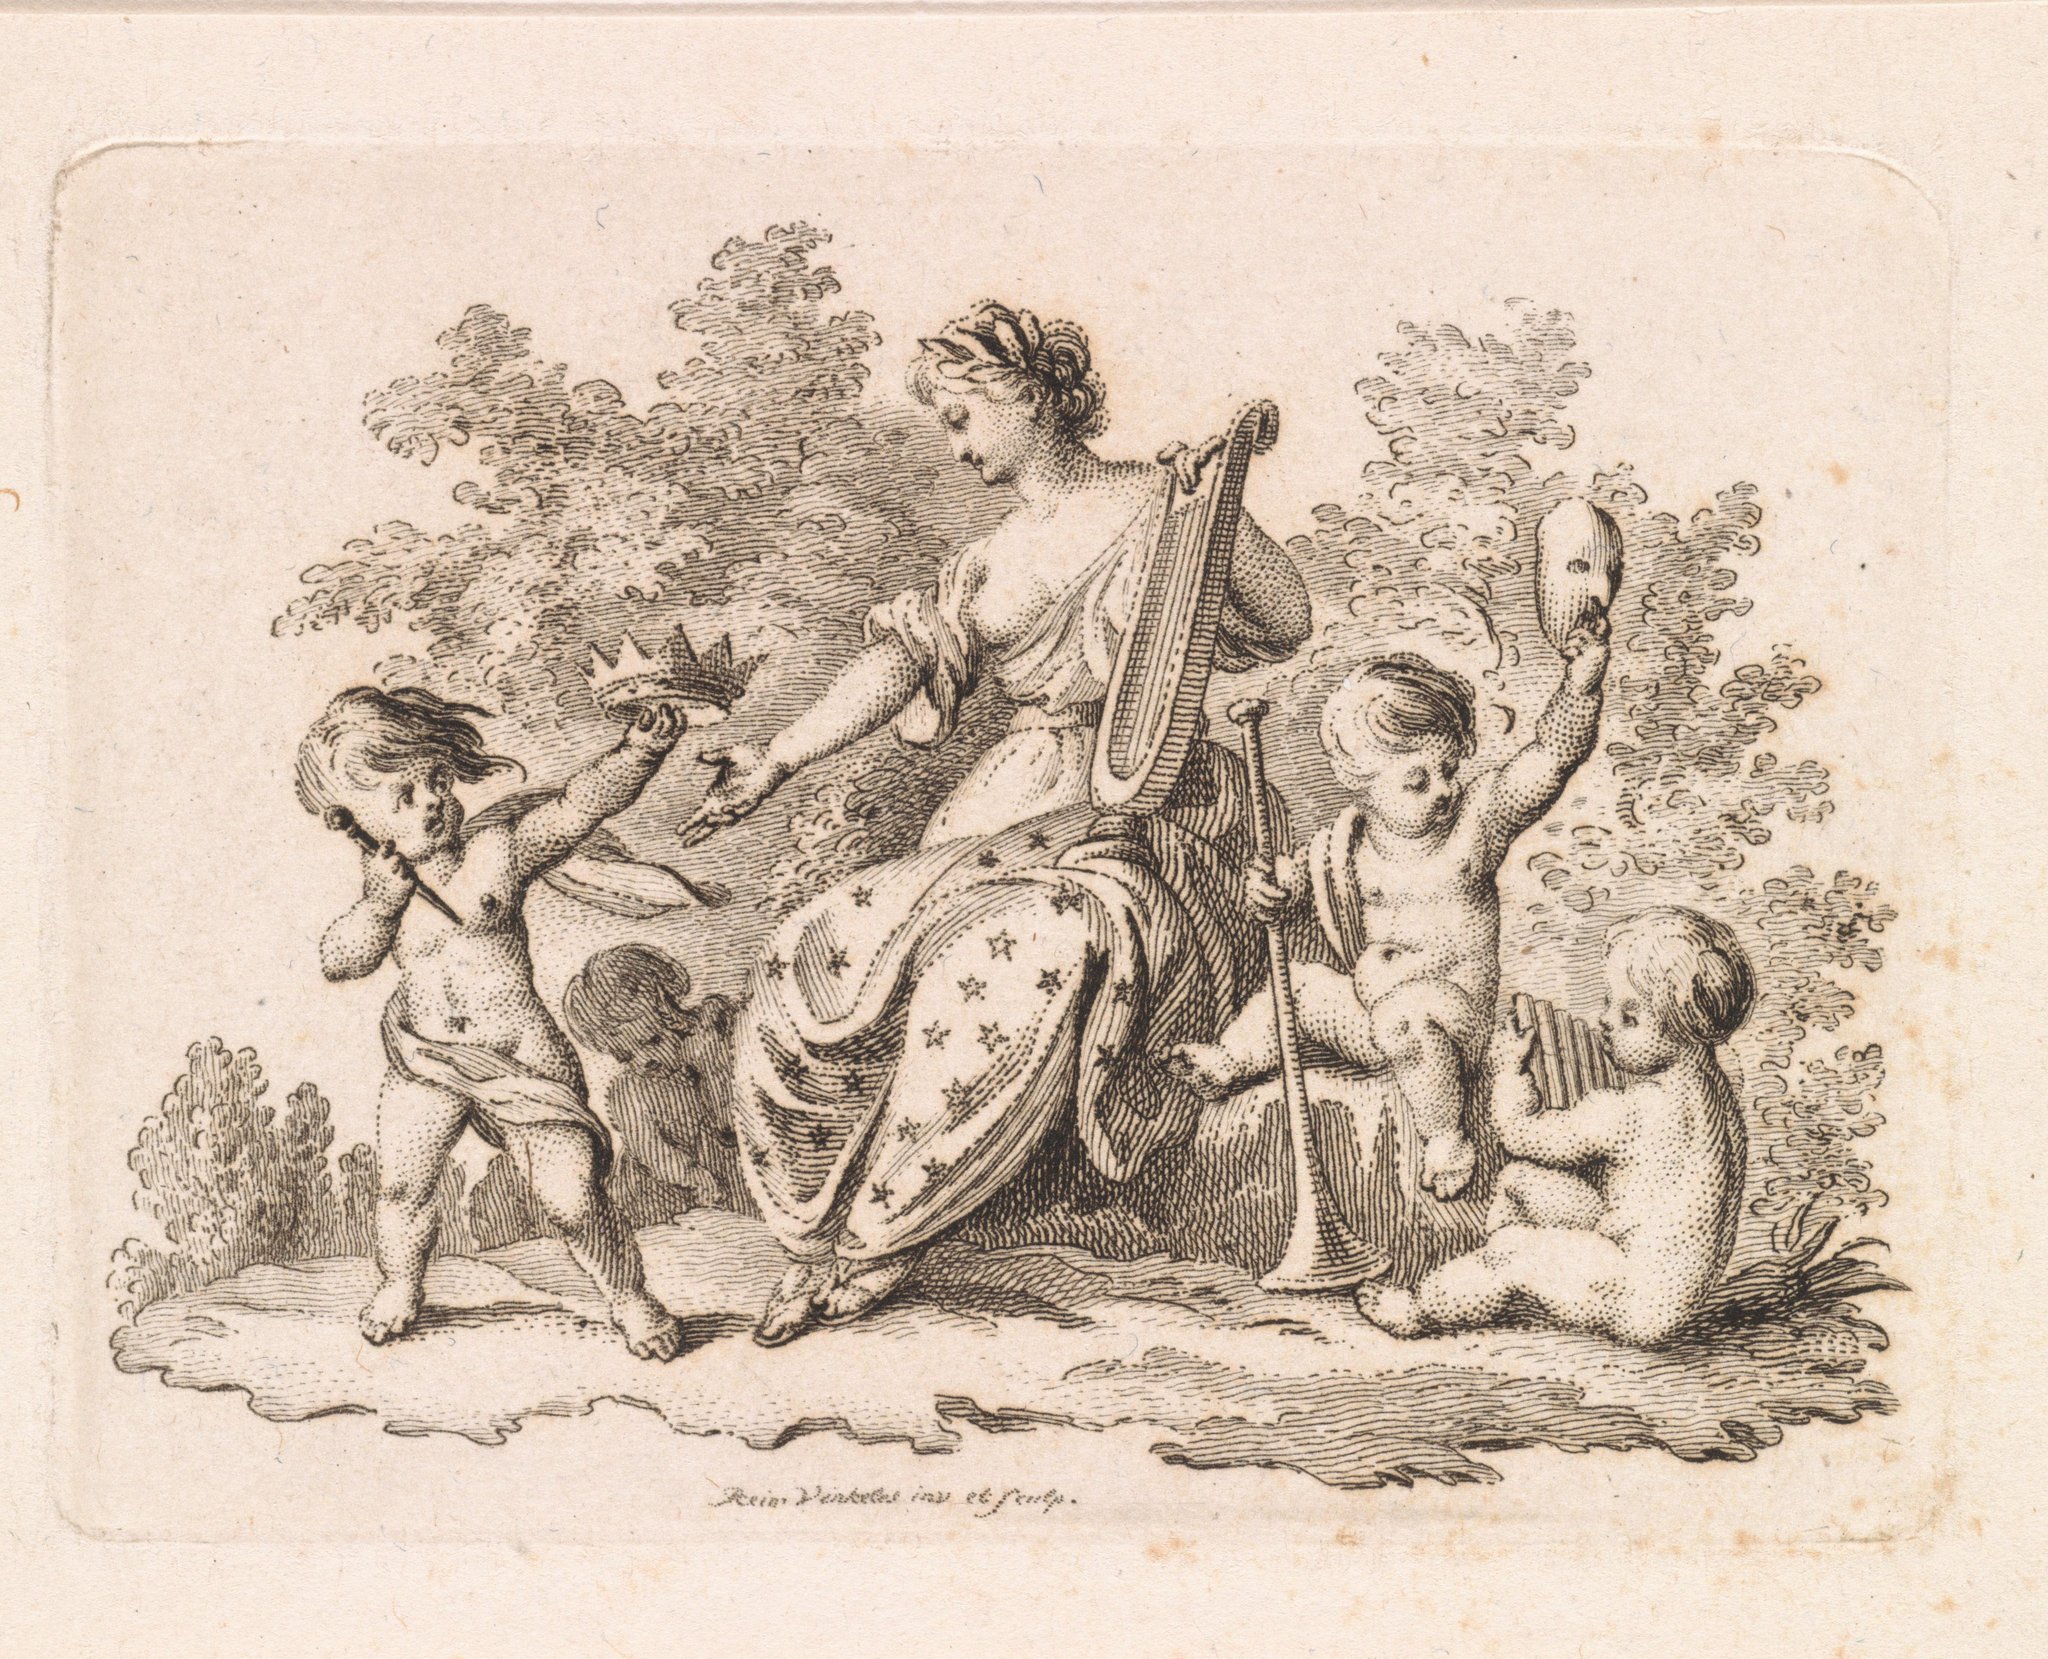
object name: print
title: Titelpagina voor: Adriaan Pietersz. Loosjes, Tooneeloefeningen, 1790-1793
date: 1790-1793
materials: paper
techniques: engraving, etching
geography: haarlem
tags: mask, harp, cupids: 'amores', 'amoretti', 'putti'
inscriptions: collector's mark: Lugt 2228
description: Gebruikt als titelpagina voor: Adriaan Pietersz. Loosjes, Tooneeloefeningen. Uitgegeven in vier delen. Haarlem: A. Loosjes, 1790-1793.